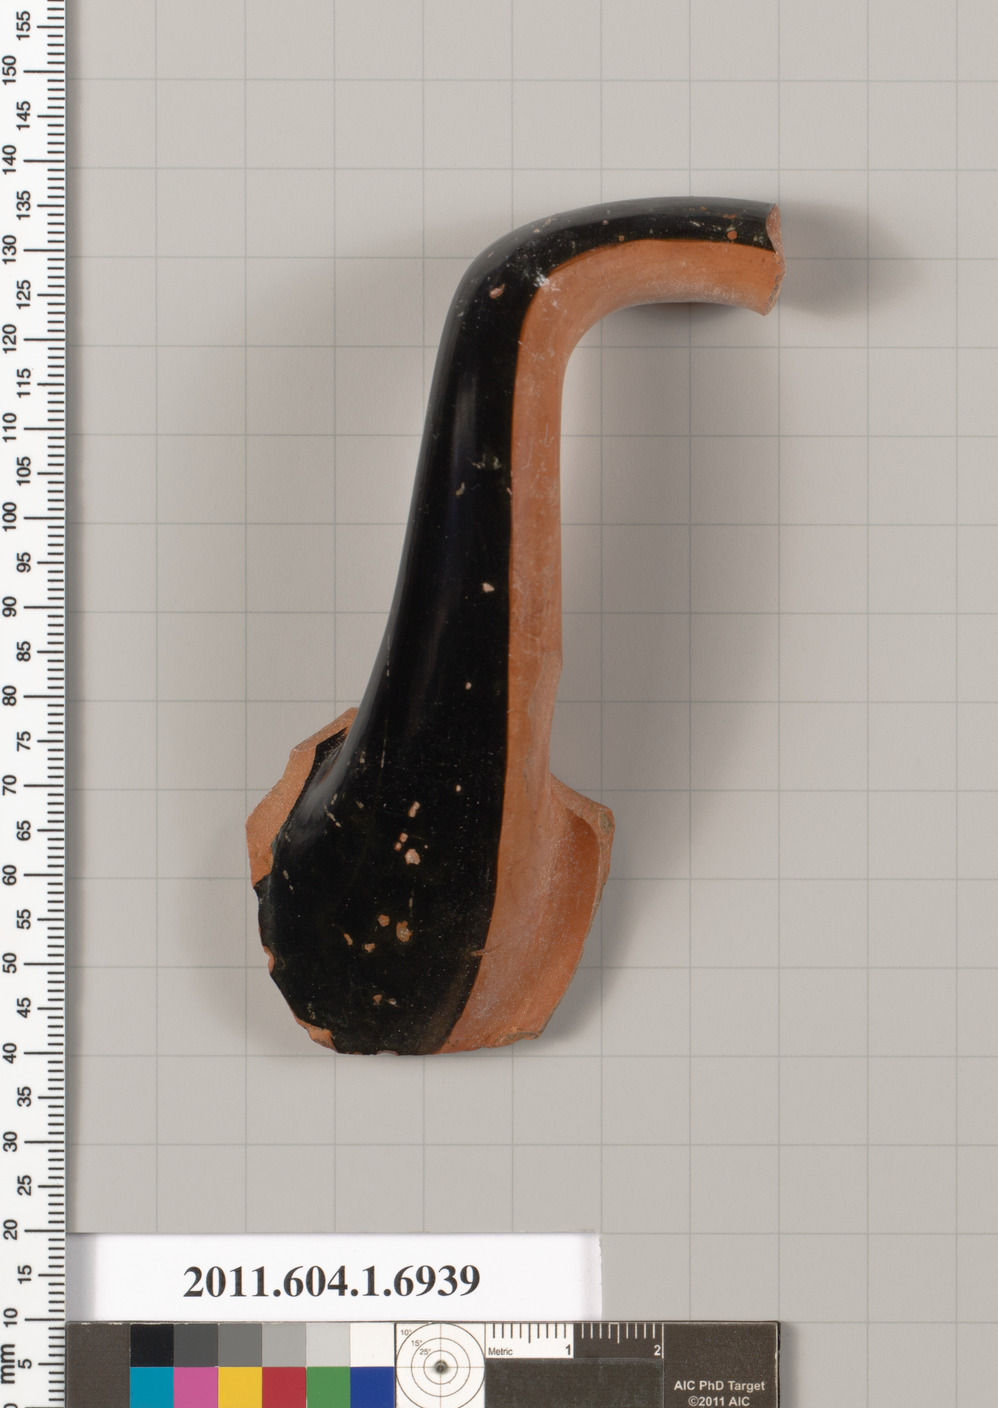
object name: kylix fragment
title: Terracotta fragment of a kylix (drinking cup)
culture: greek, attic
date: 490-470 BCE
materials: terracotta